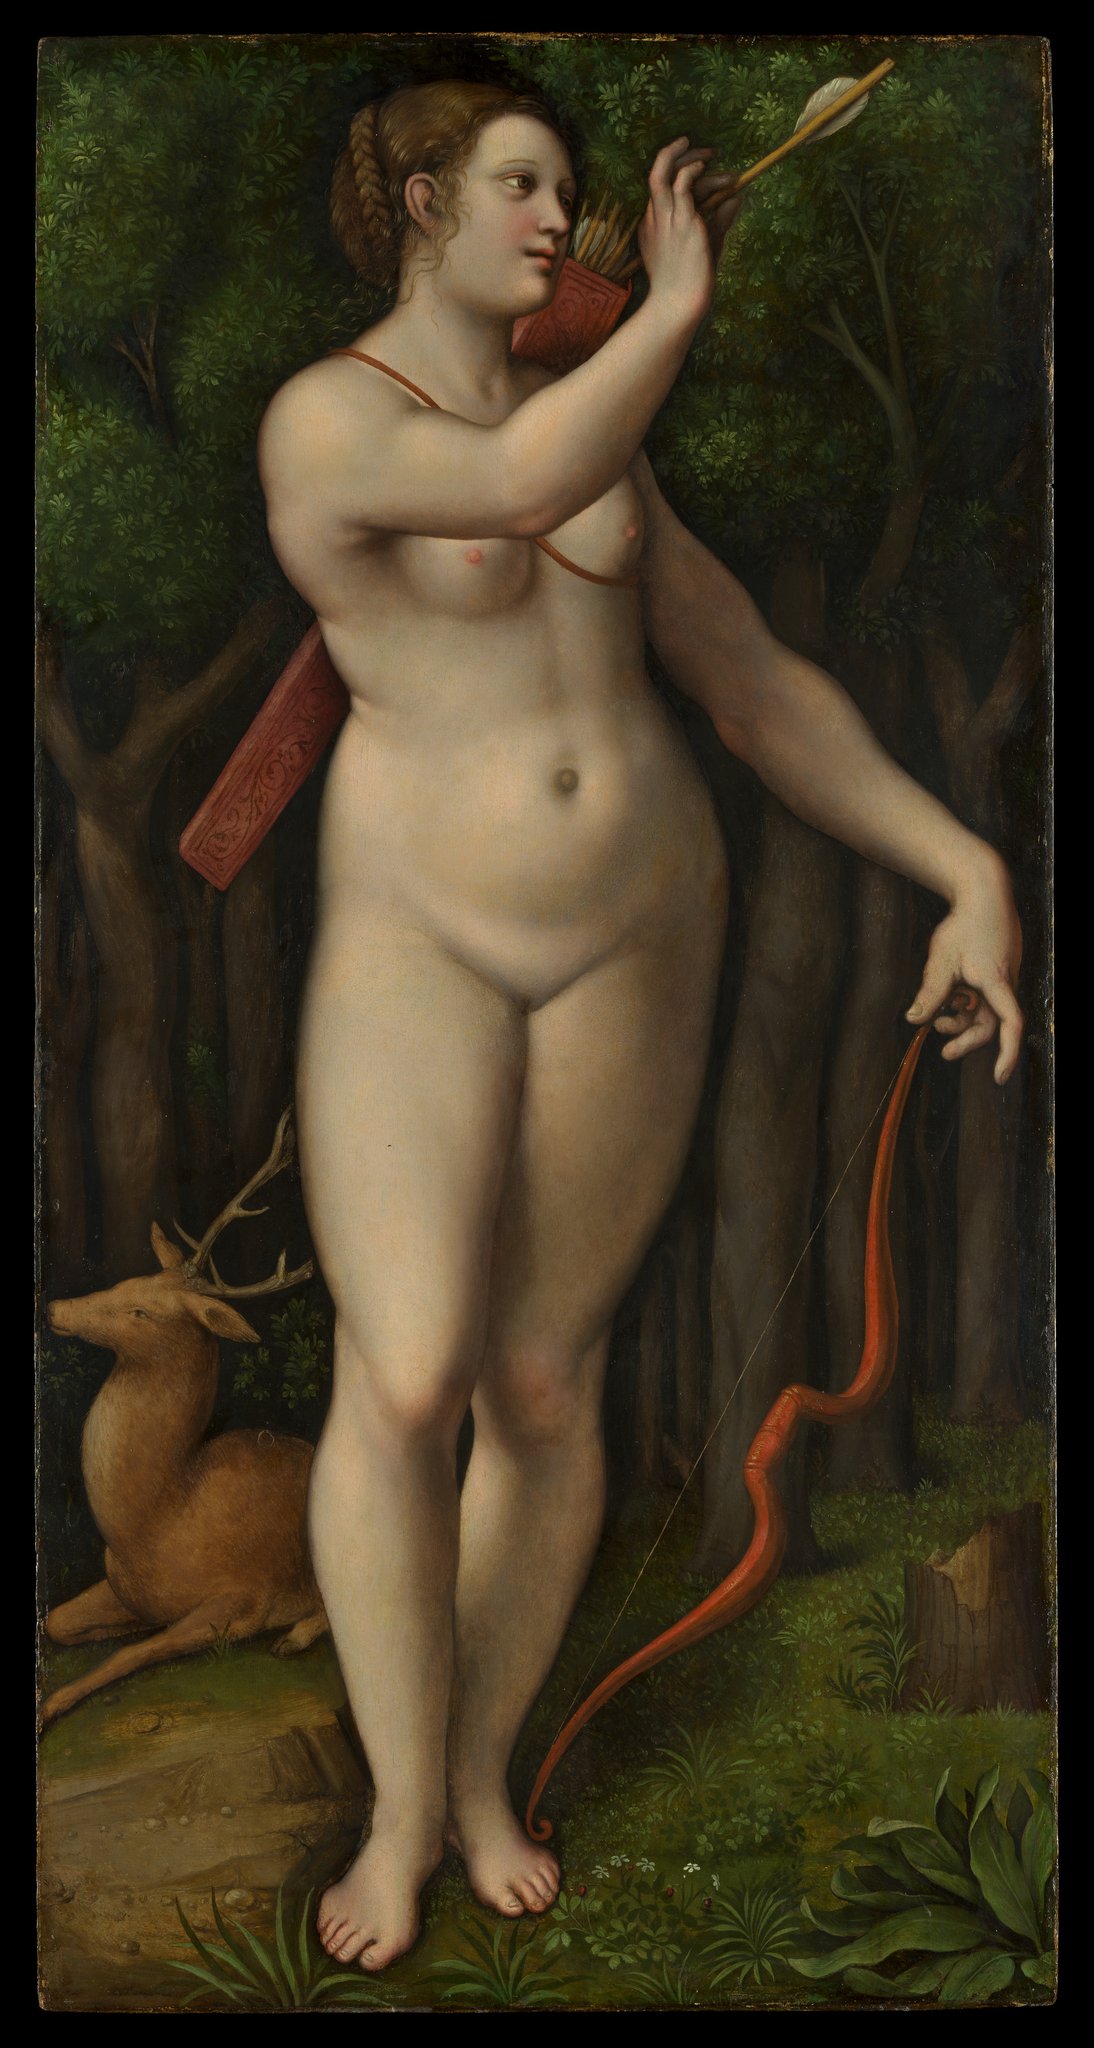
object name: painting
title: Diana the Huntress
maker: giampietrino (giovanni pietro rizzoli)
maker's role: artist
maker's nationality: italian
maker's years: 1495-1553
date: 1526-1549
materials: oil, wood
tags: bow and arrow,female nudes,diana,deer